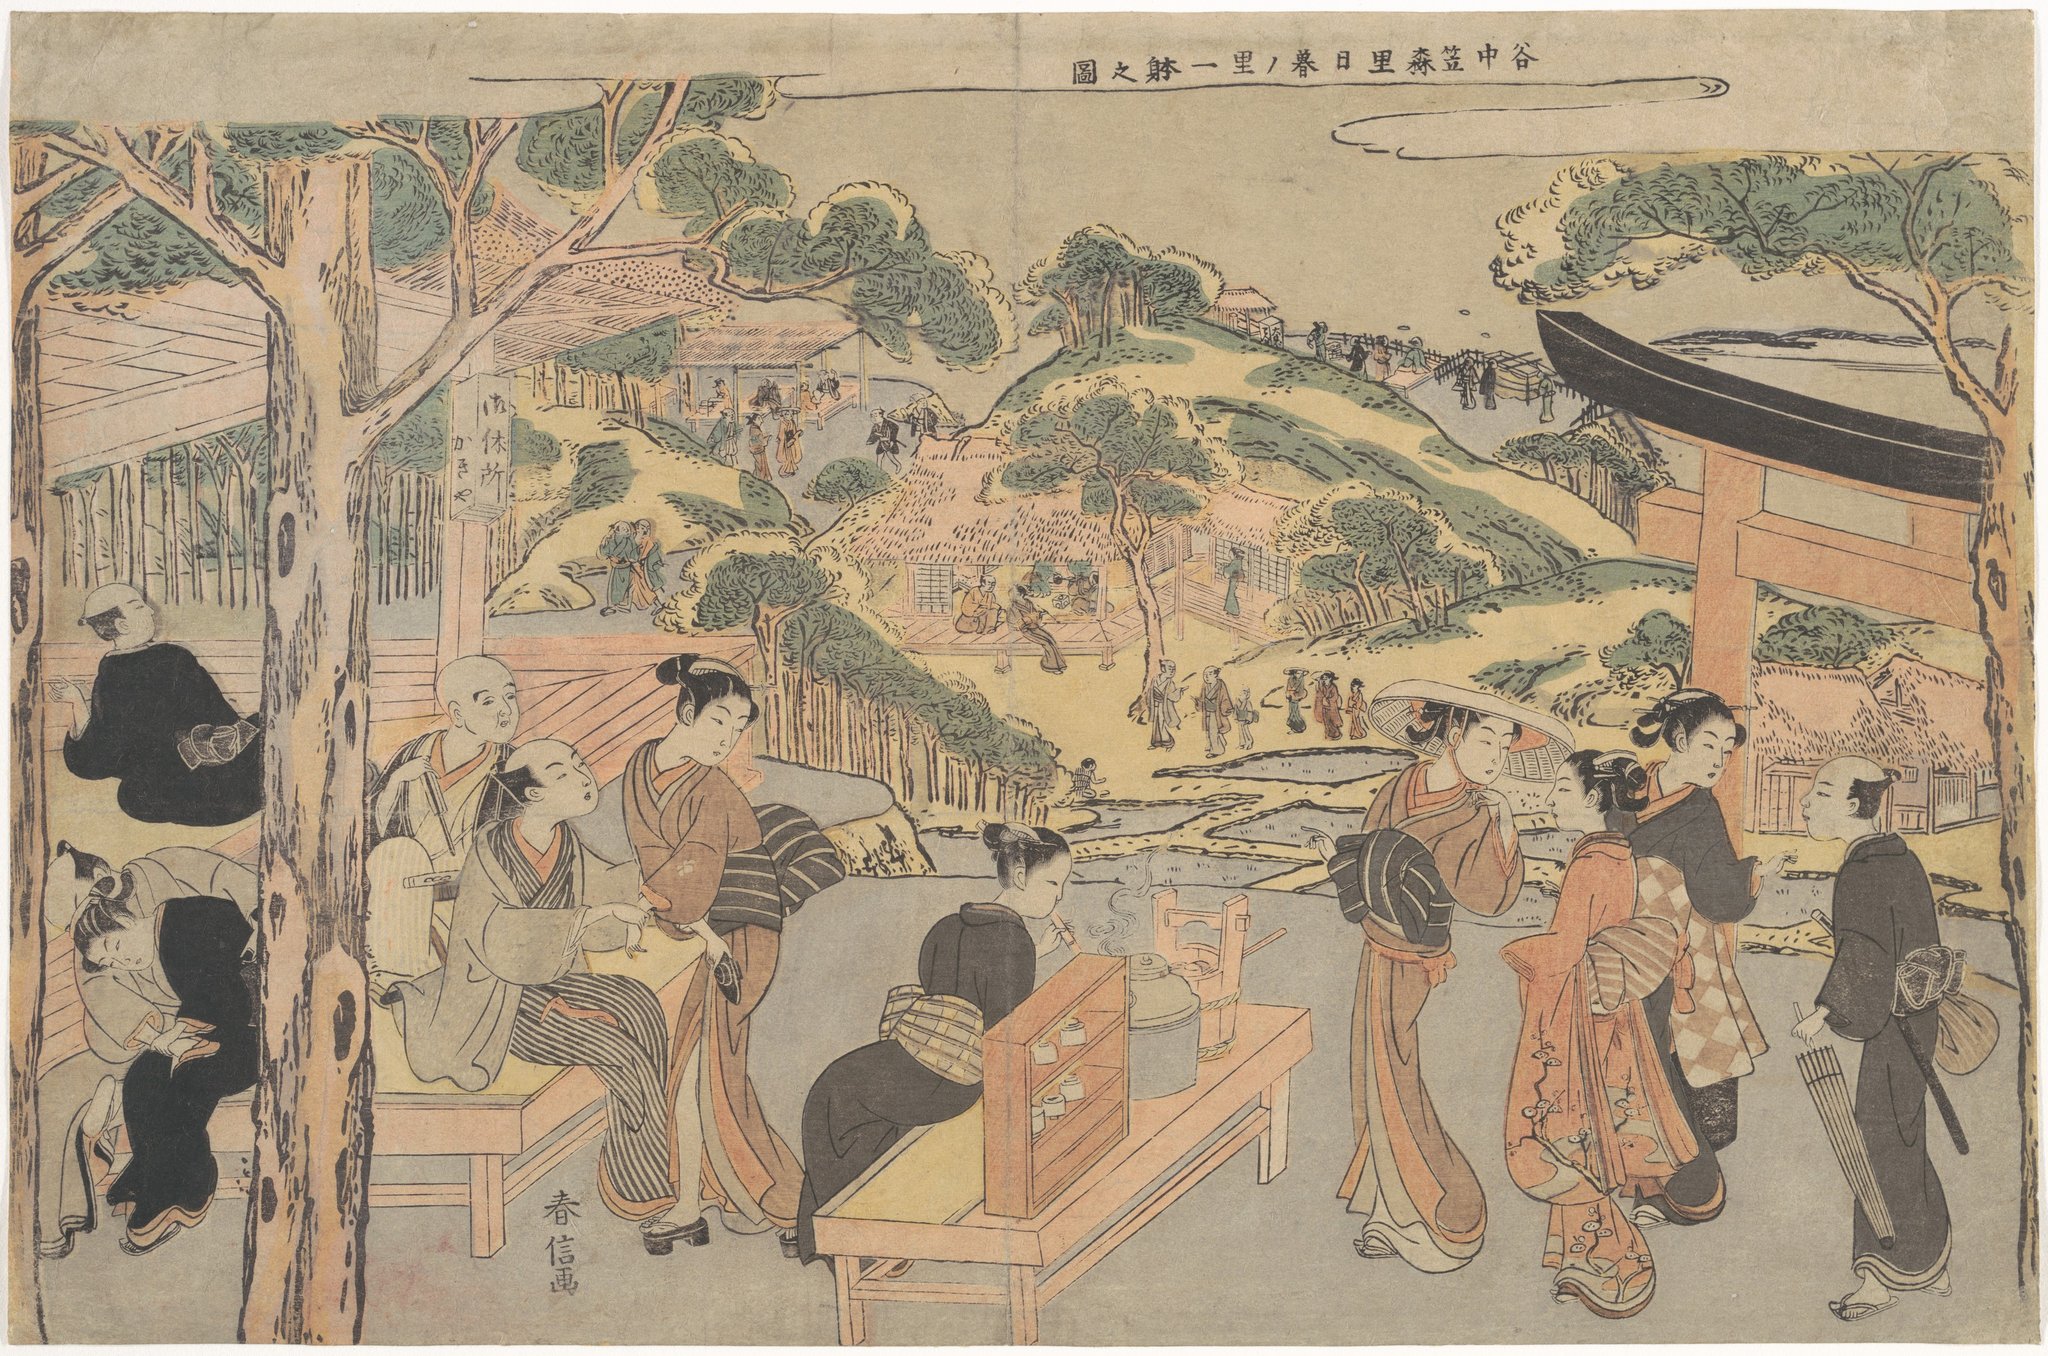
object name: print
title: Osen of the Kagiya Teahouse at Kasamori Shrine with a View of Nippori in Yanaka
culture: japanese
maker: suzuki harunobu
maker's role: artist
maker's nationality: japanese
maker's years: 1725-1770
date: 1768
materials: ink, paper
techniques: woodblock print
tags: men,women,genre scene